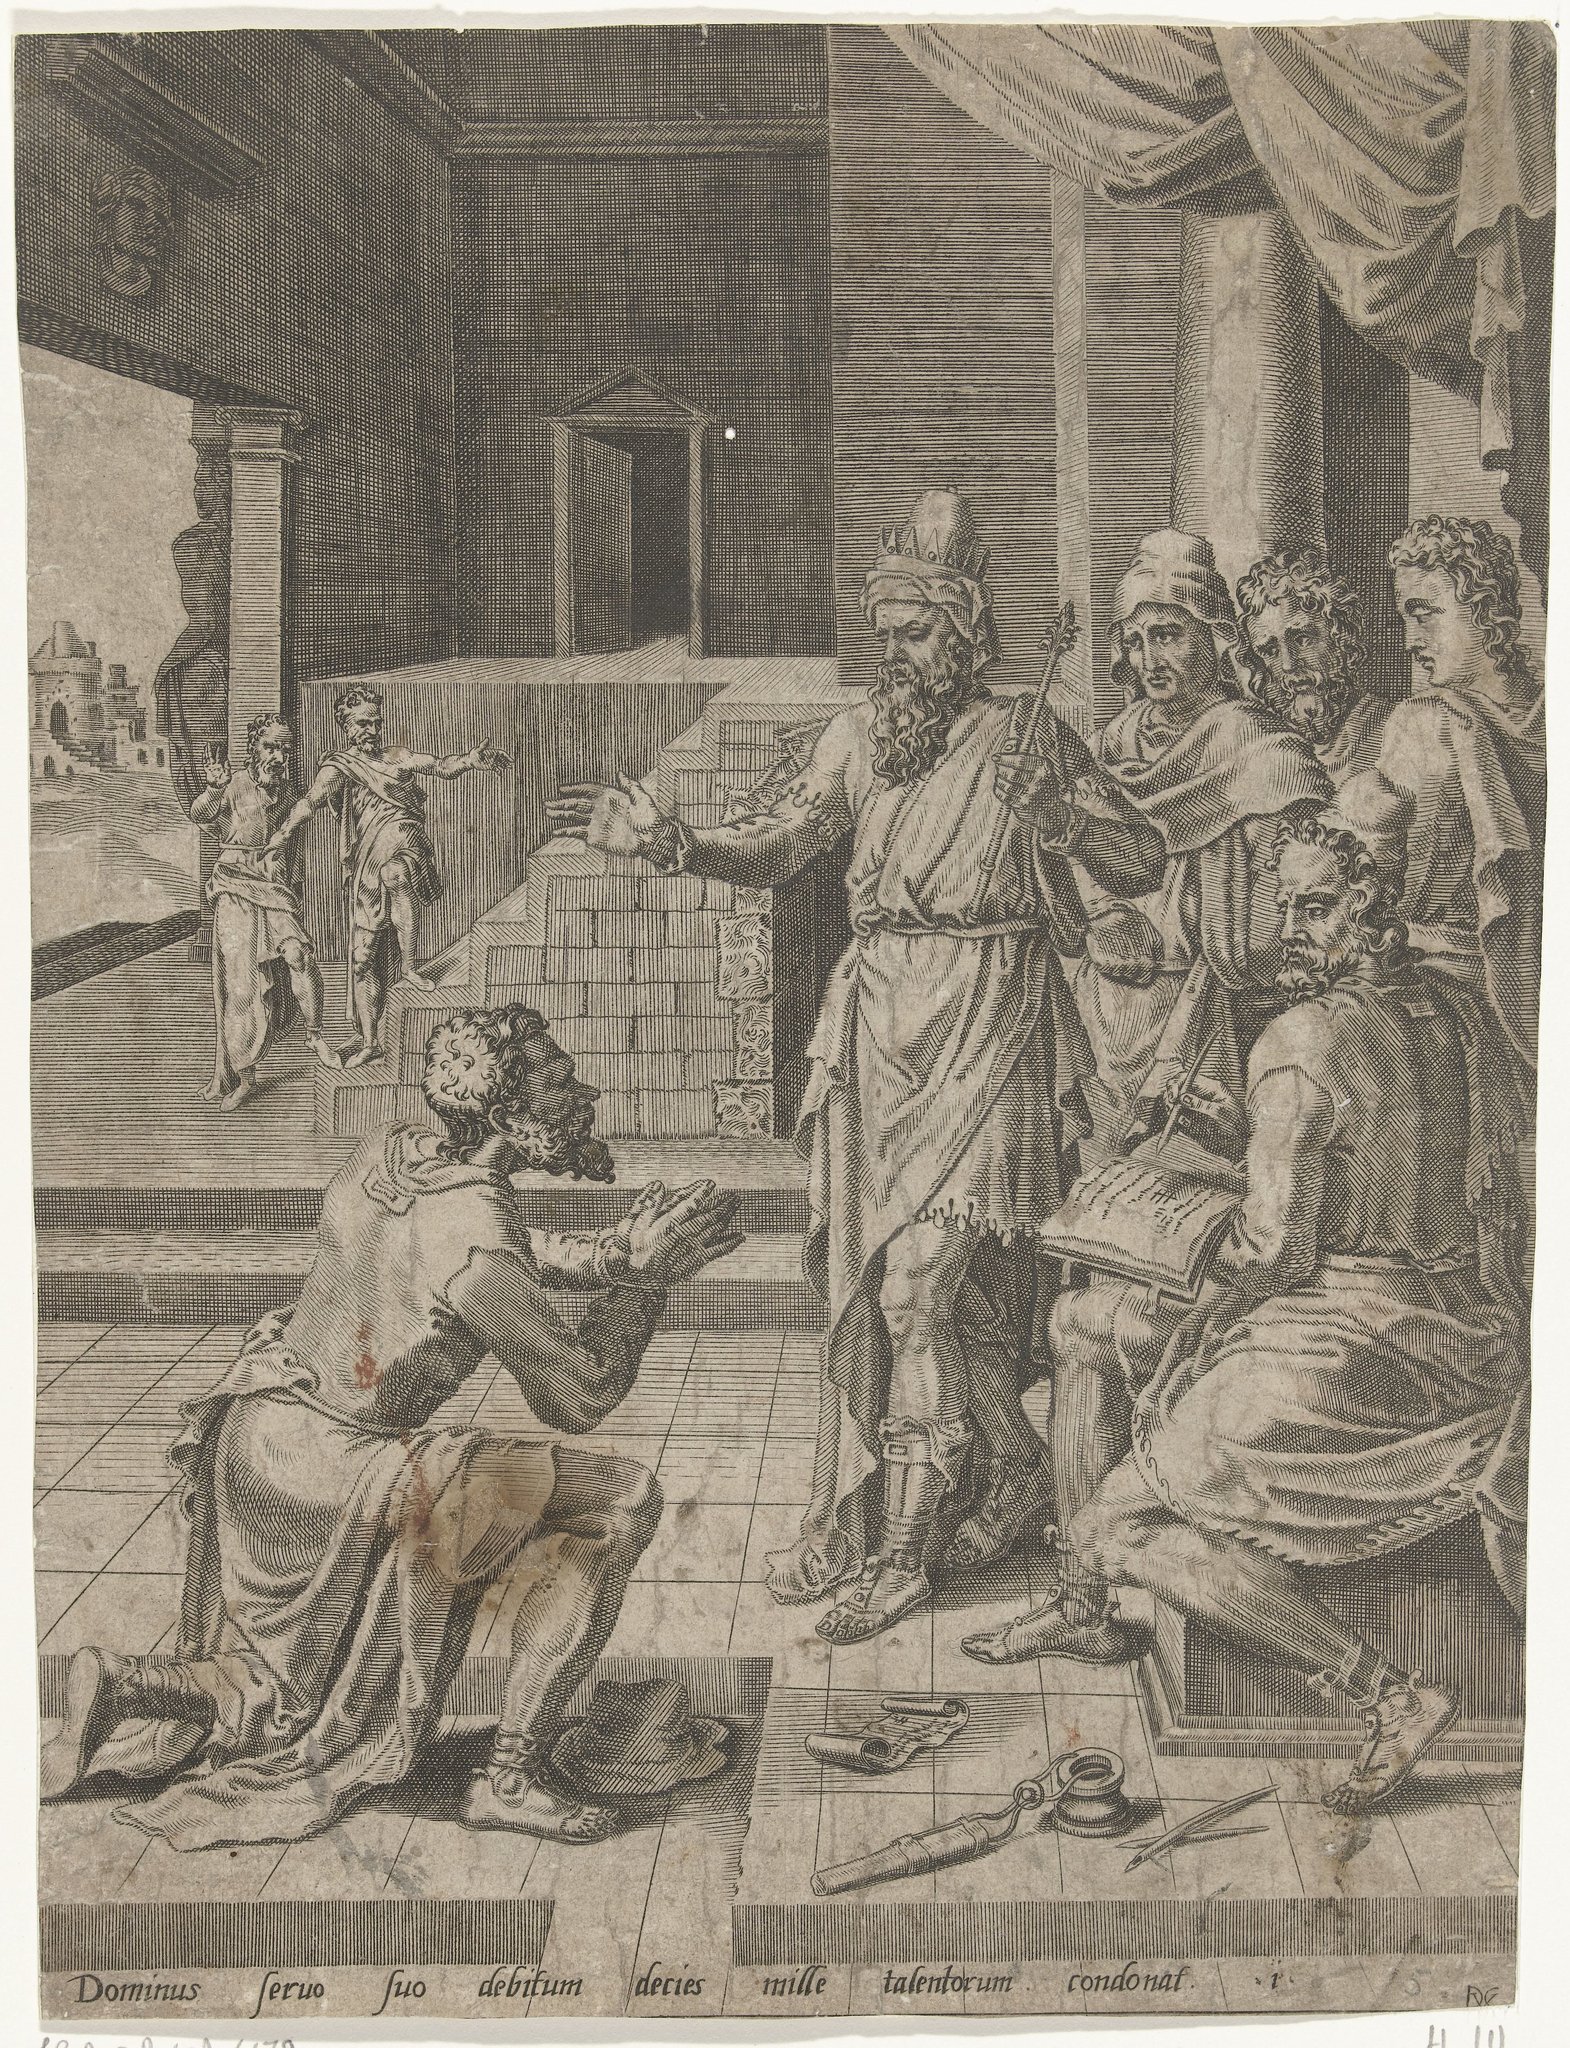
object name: print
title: Kwijtschelding van de schuld van de knecht door de koning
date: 1554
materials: paper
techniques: engraving, etching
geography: haarlem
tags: the unmerciful servant: the king forgives him his debts ~ parable of christ (matthew 18:23-35)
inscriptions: collector's mark: Lugt 2228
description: De ondankbare knecht zit op zijn knieën en smeekt de koning om genade. De koning scheldt daarop de schuld van 10.000 talent kwijt. De prent heeft een Latijns onderschrift en maakt deel uit van een vierdelige serie over de gelijkenis van de ondankbare knecht.